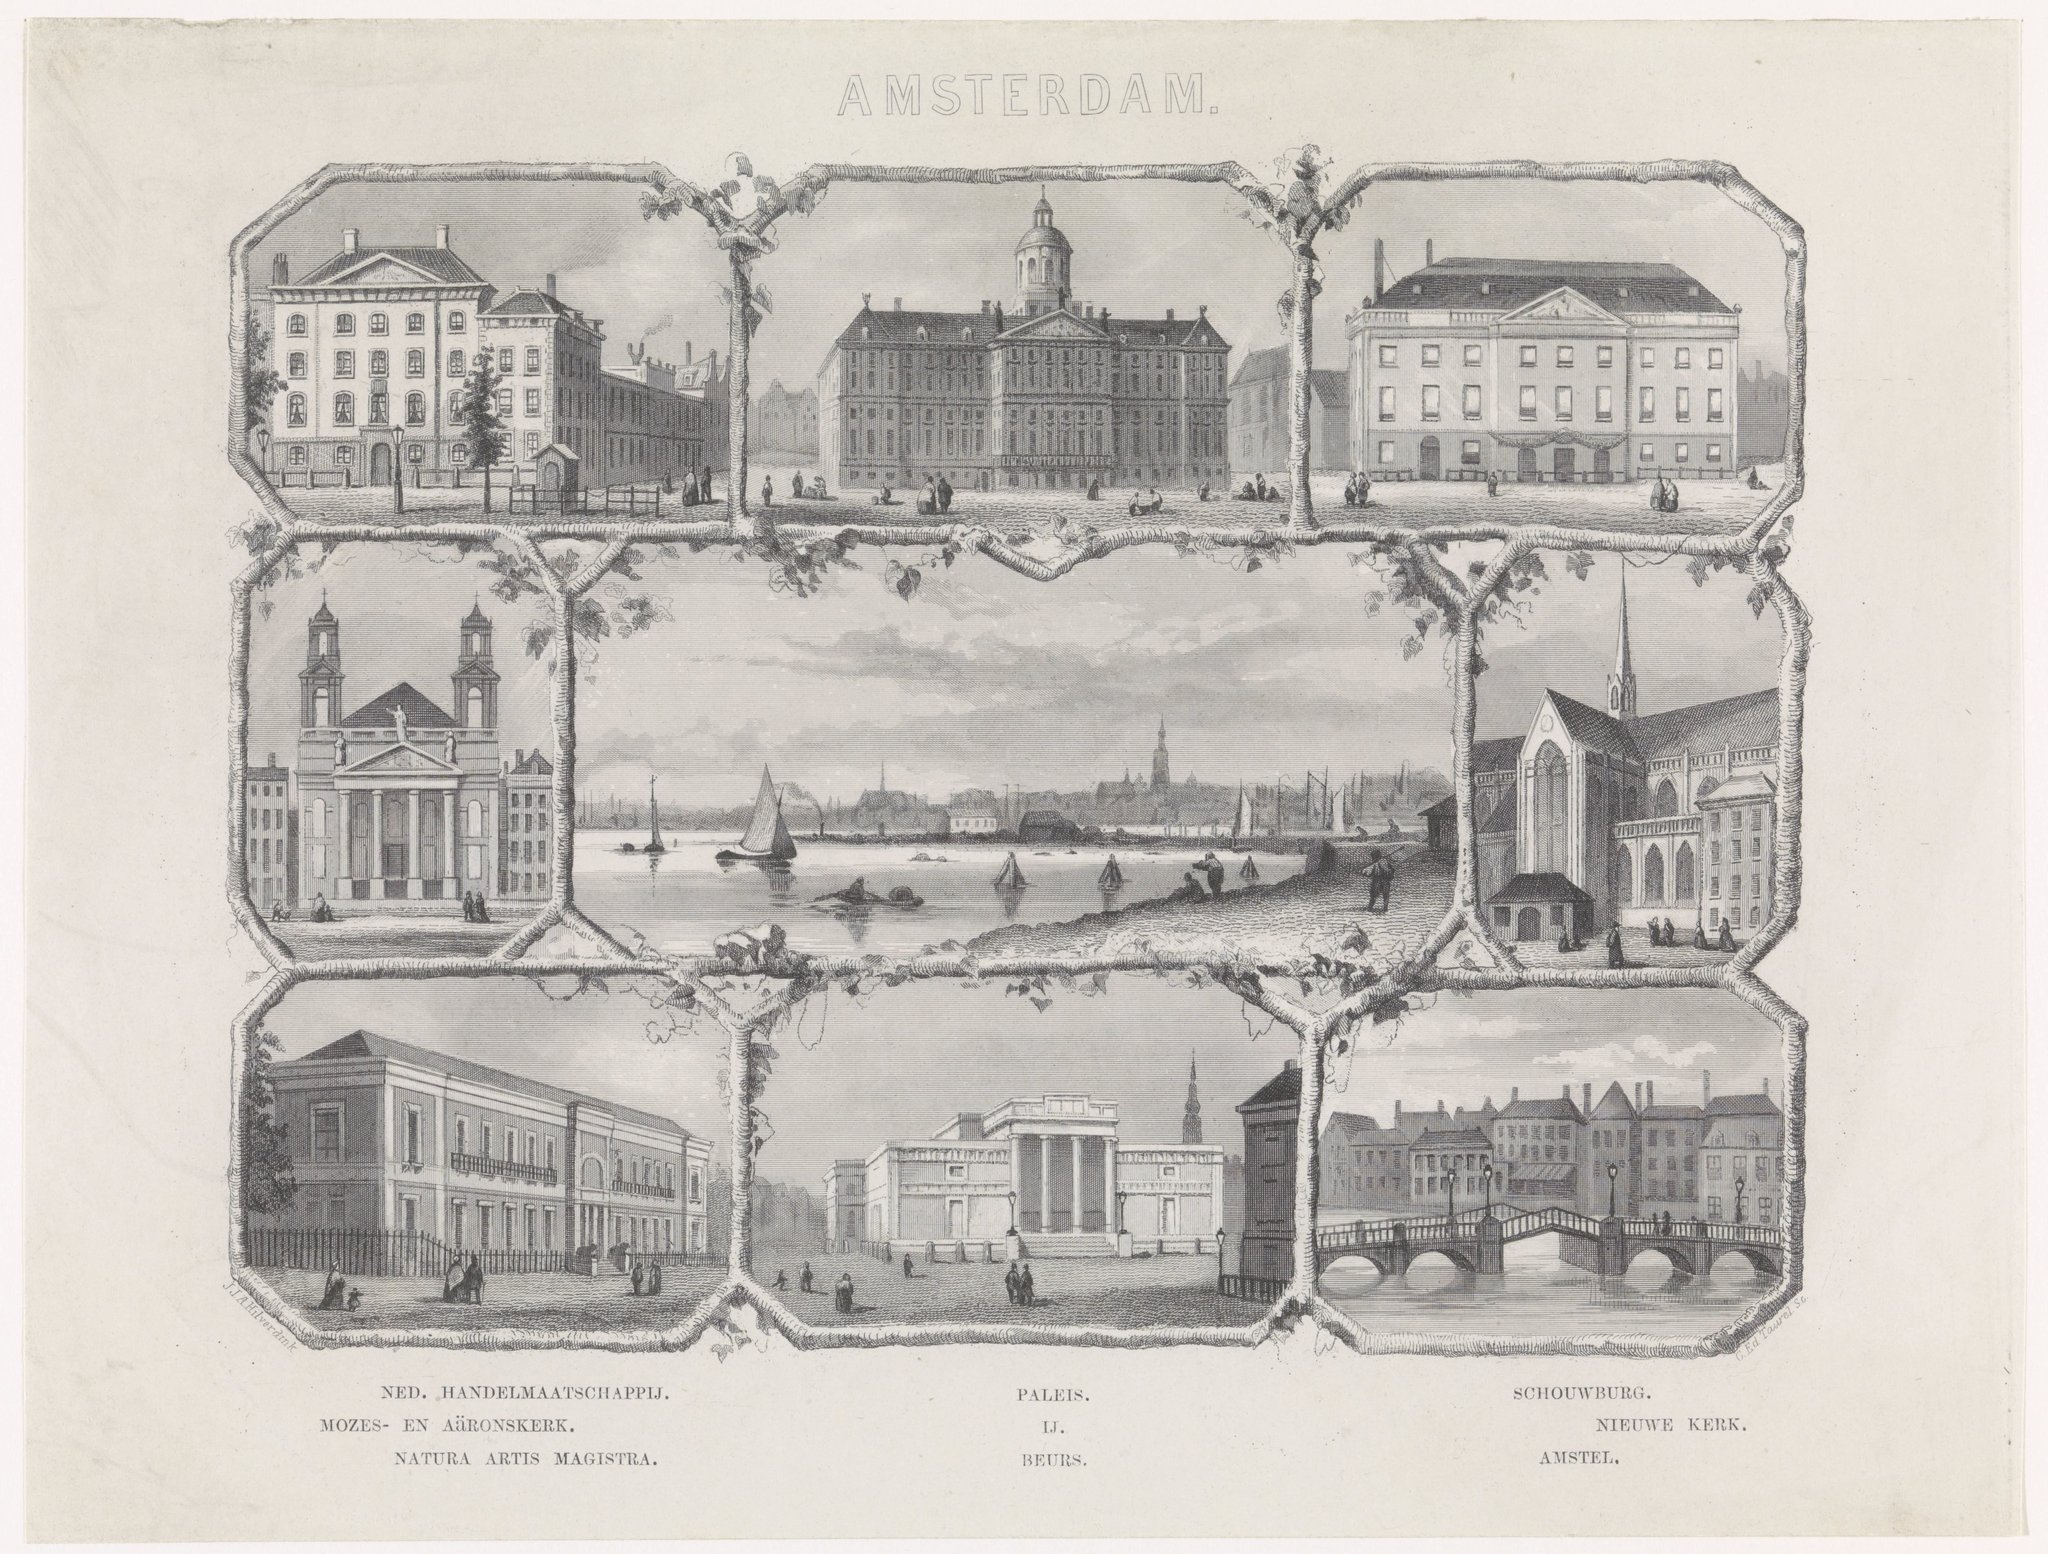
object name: print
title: Negen gezichten te Amsterdam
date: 1841-1874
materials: paper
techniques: etching, engraving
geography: amsterdam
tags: royal palace of amsterdam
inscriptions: collector's mark: Lugt 2228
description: Negen gezichten te Amsterdam. In het midden een geizcht op het IJ. Daaromheen: de Nederlandsche Handelsmaatschappij, het paleis op de Dam, de schouwburg, de Mozes- en Aäronkerk, de Nieuwe kerk, Artis, de beurs van Zocher en een gezicht op de Amstel.